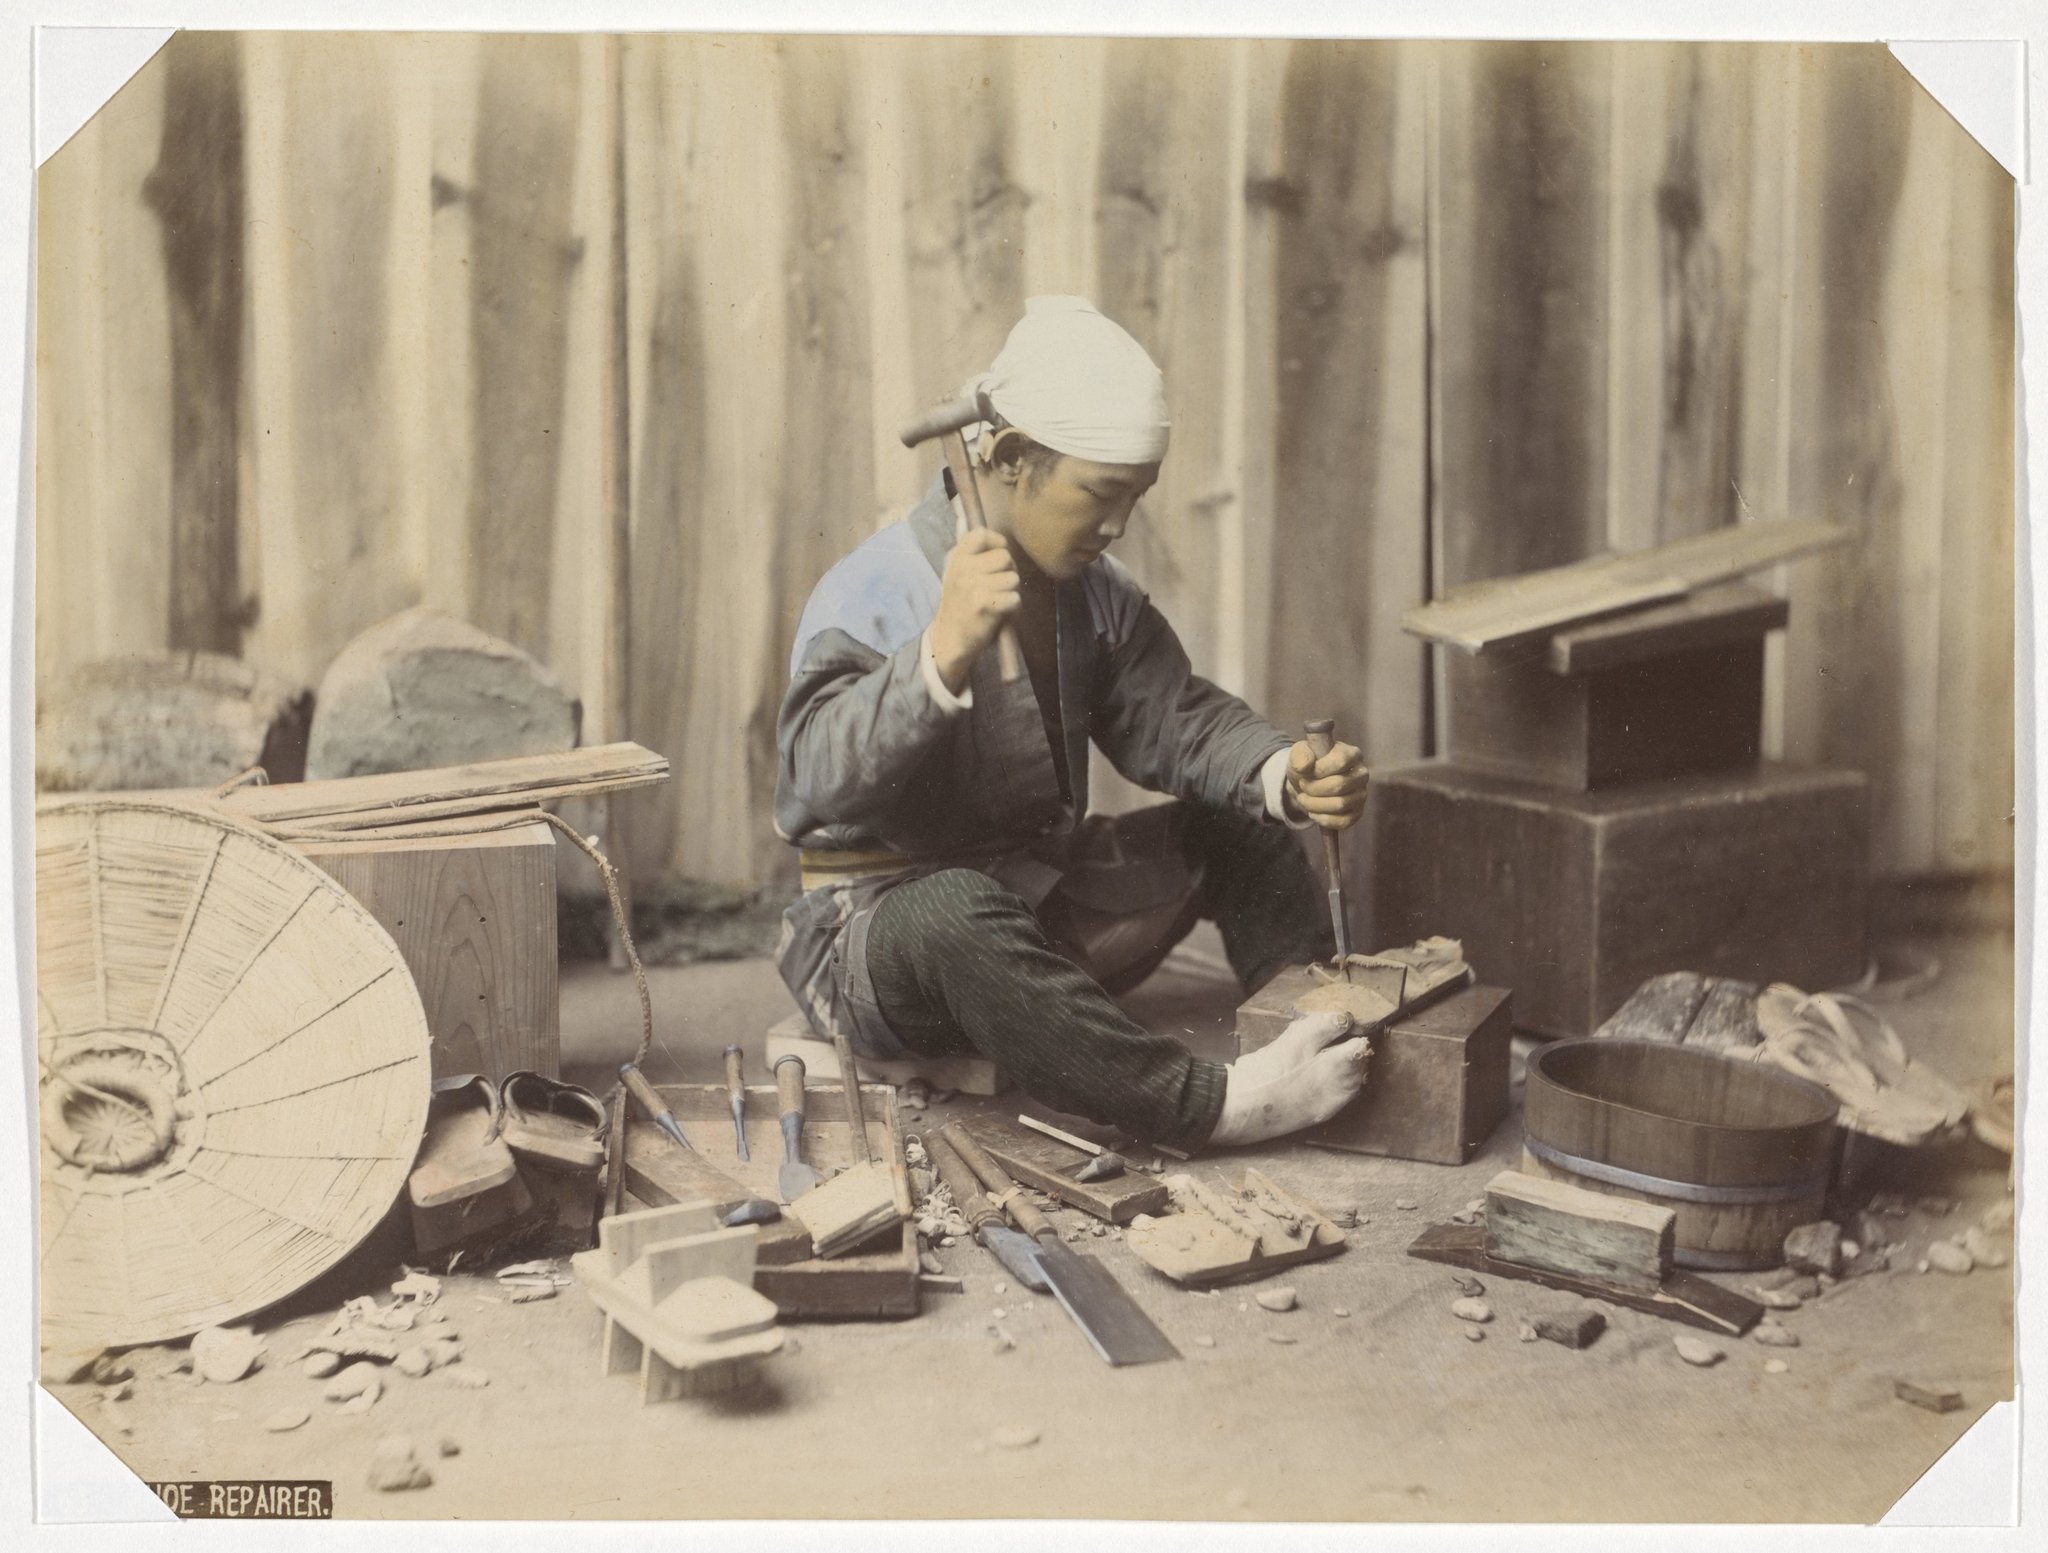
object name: photograph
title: Shoe Repairer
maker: Anonymous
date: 1890-1894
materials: cardboard, paper, photographic support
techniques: albumen print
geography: japan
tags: shoe-maker, cobbler, japan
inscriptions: negative number: ‘63’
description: Onderdeel van Album met 69 foto's van een reis door Japan.